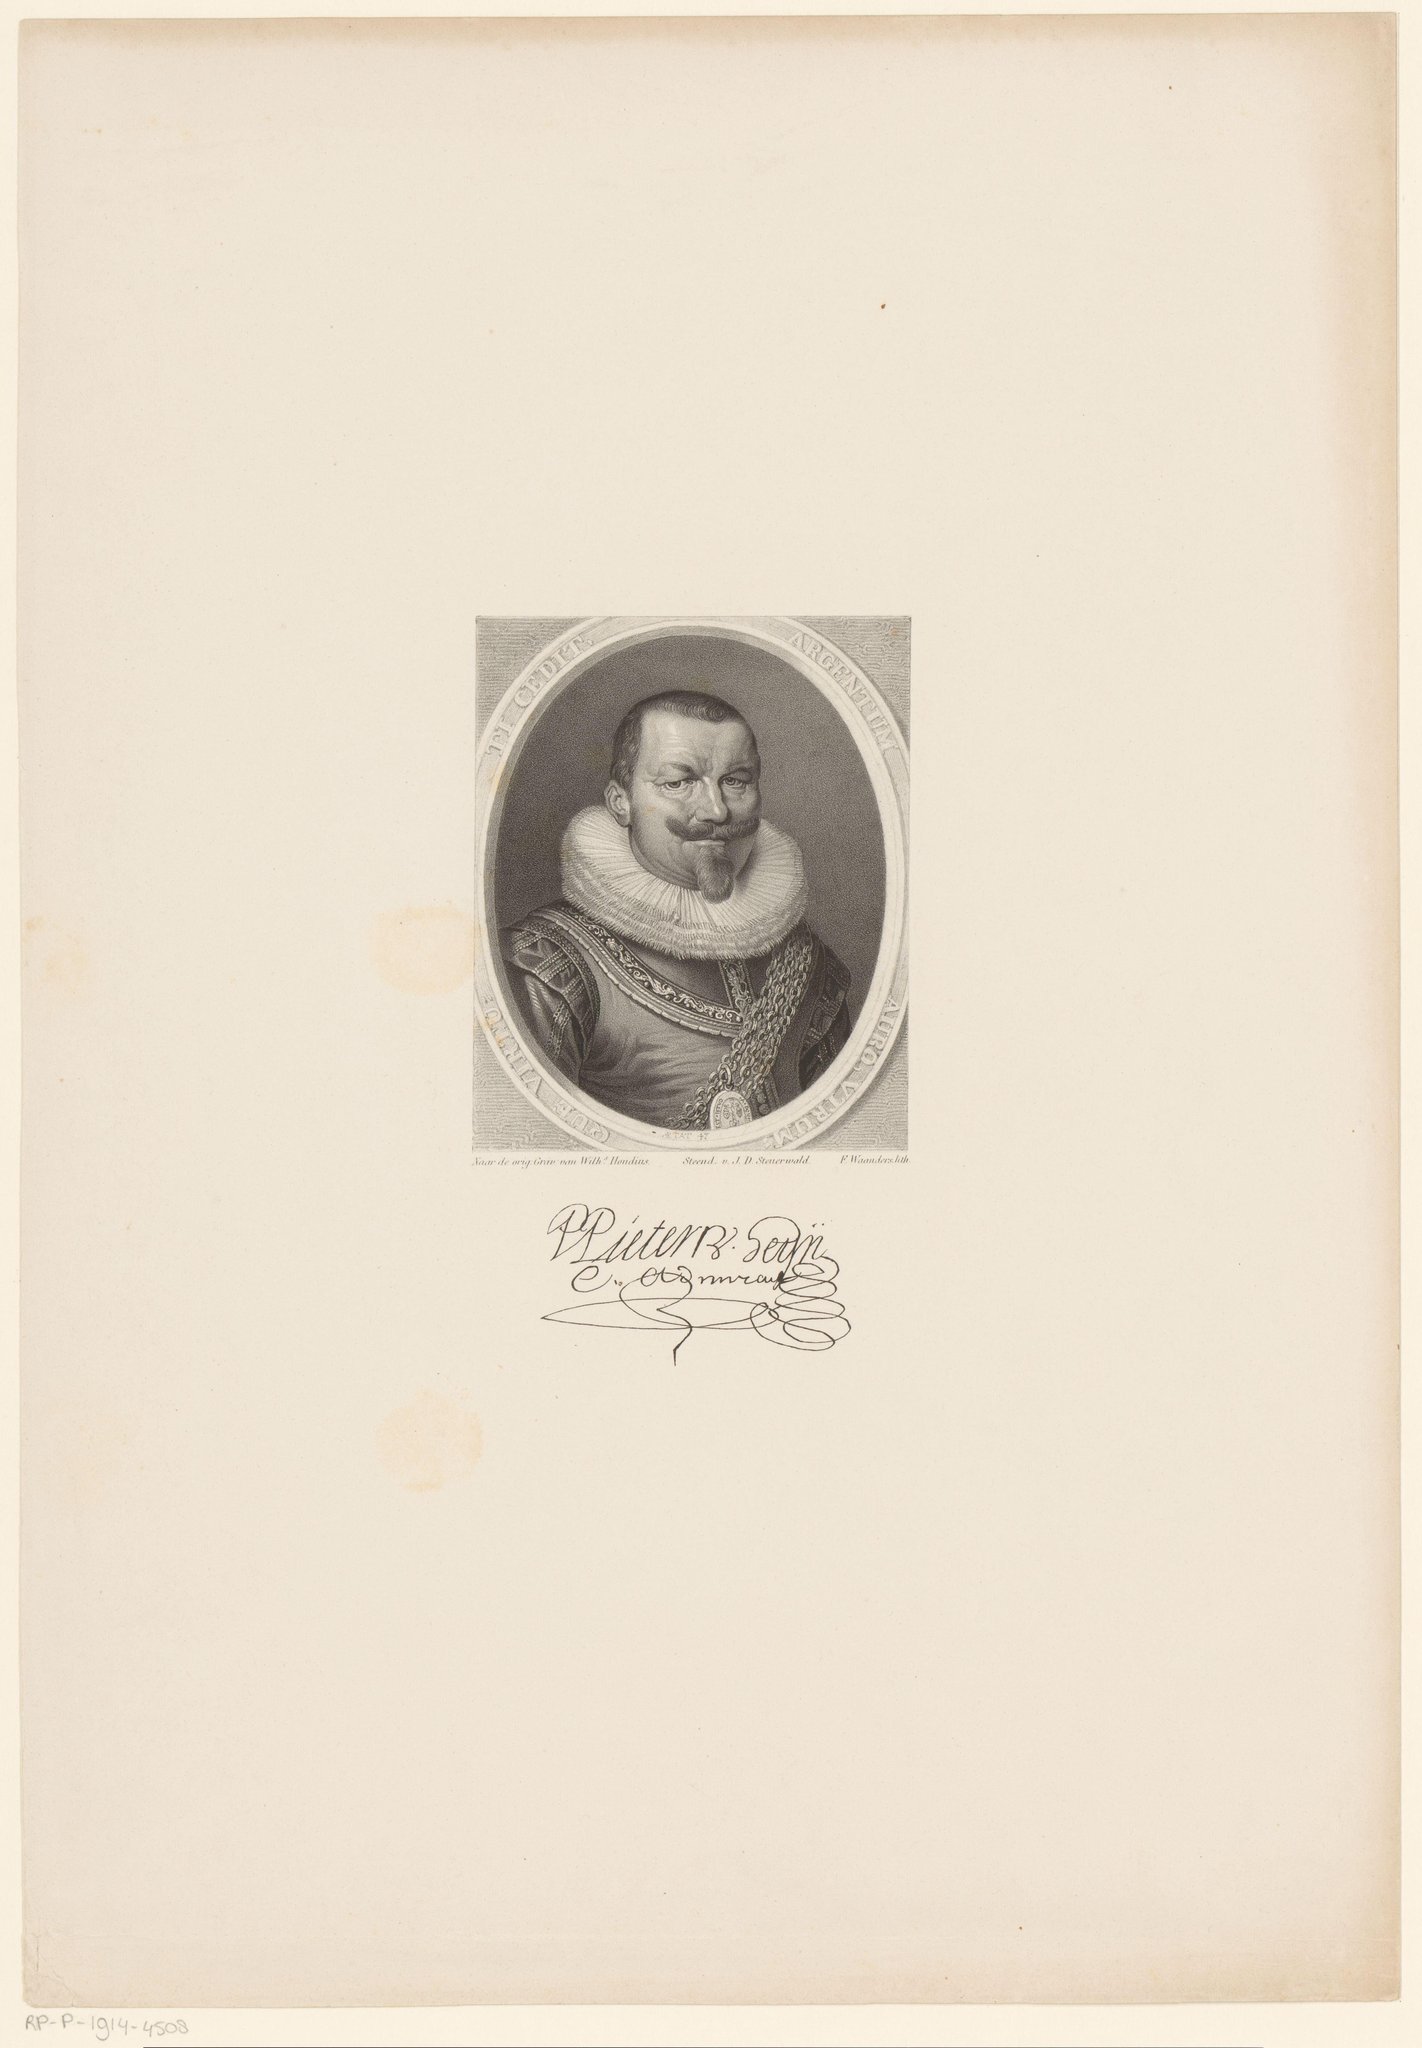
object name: print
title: Portret van Piet Hein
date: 1833-1863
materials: paper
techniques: lithograph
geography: the hague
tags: delfshaven, historical persons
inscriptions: collector's mark: Lugt 2228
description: Onder het portret de signatuur van de geportretteerde.